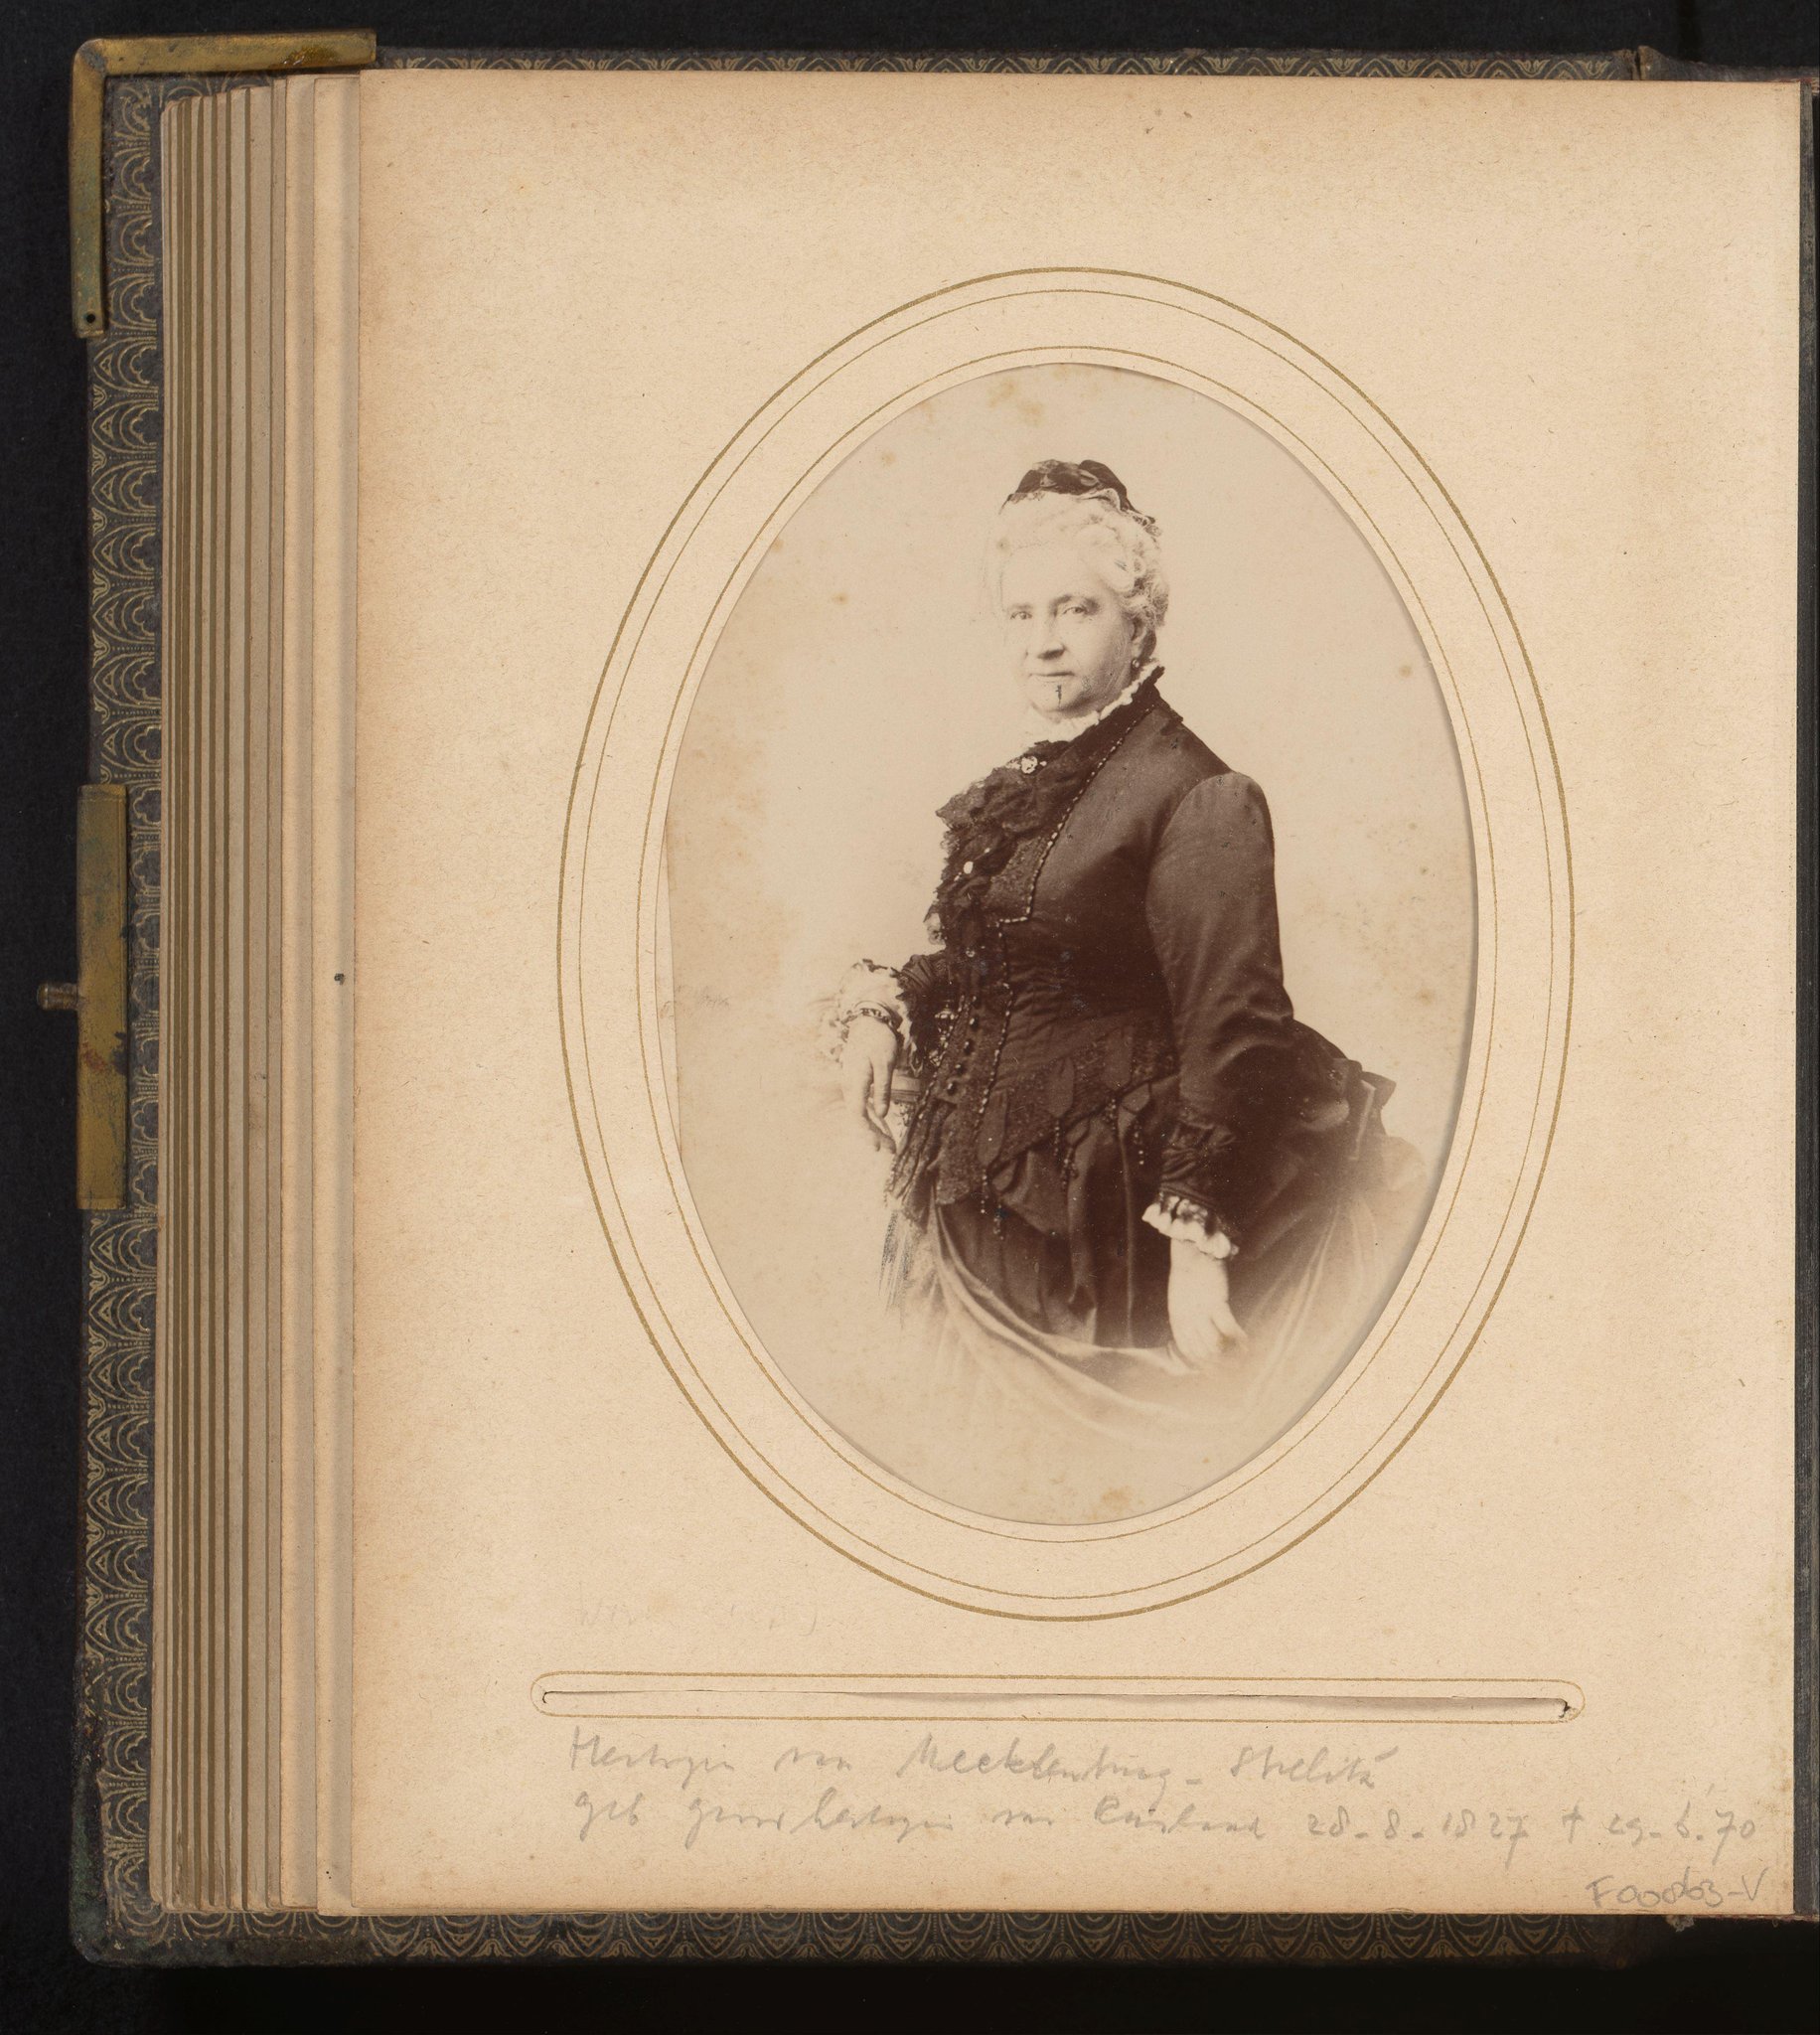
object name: photograph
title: Portret van hertogin van Mecklenburg-Strelitz, geboren groothertogin van Rusland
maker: hermann krull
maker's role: fotograaf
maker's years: 1831-1907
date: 1860-1870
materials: cardboard, photographic support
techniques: albumen print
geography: neustrelitz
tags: historical persons - bb - woman, ruler, sovereign - bb - female ruler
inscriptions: annotation: ‘Hertogin van Meklenburg/ Streliz/ neé grande duchesse de Russie/ a St. Peterburg 28 Aout 1827/ morte le 29 juin 1870/ 20,-’, inscription: ‘H. Krull/ Hofphotograph/ Neu-Strelitz’